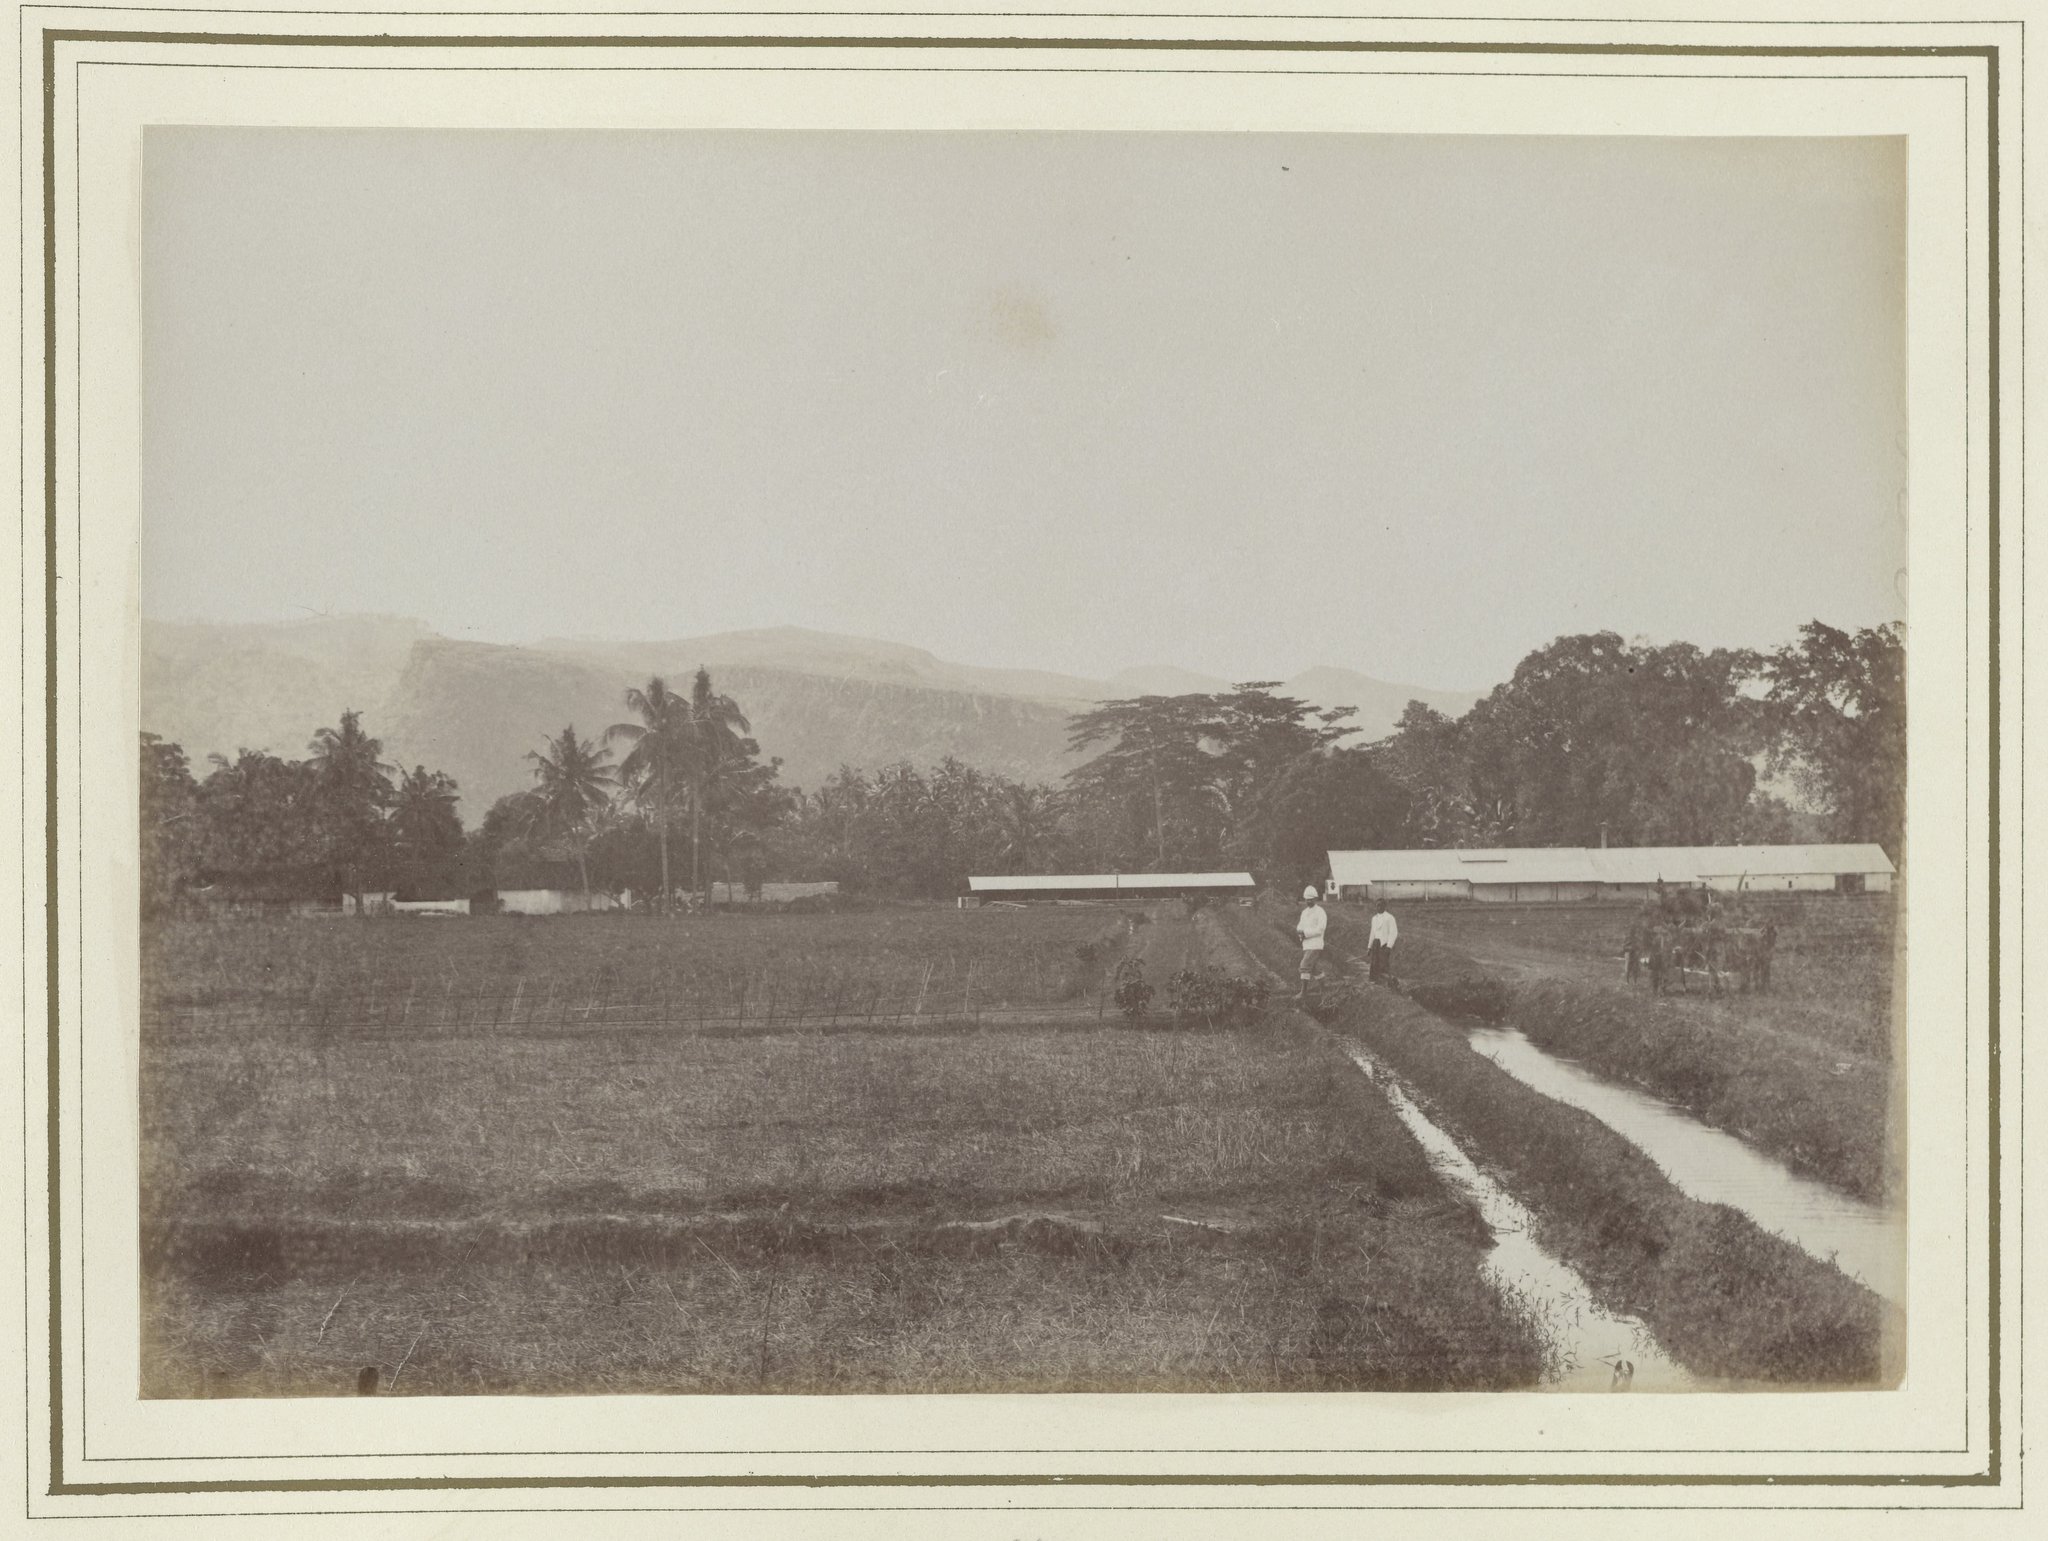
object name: photograph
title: Velden en schuren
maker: kassian céphas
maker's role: fotograaf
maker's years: 1845-1912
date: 1886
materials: photographic support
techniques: albumen print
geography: jogjakarta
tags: the hague, colonial system, plantation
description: Gezicht op velden en schuren of loodsen. Aan de rand van het veld staan een Europese en een Indonesische man. Onderdeel van het fotoalbum aangeboden aan J.M. Pijnacker Hordijk bij zijn vertrek uit Jogjakarta in 1886.